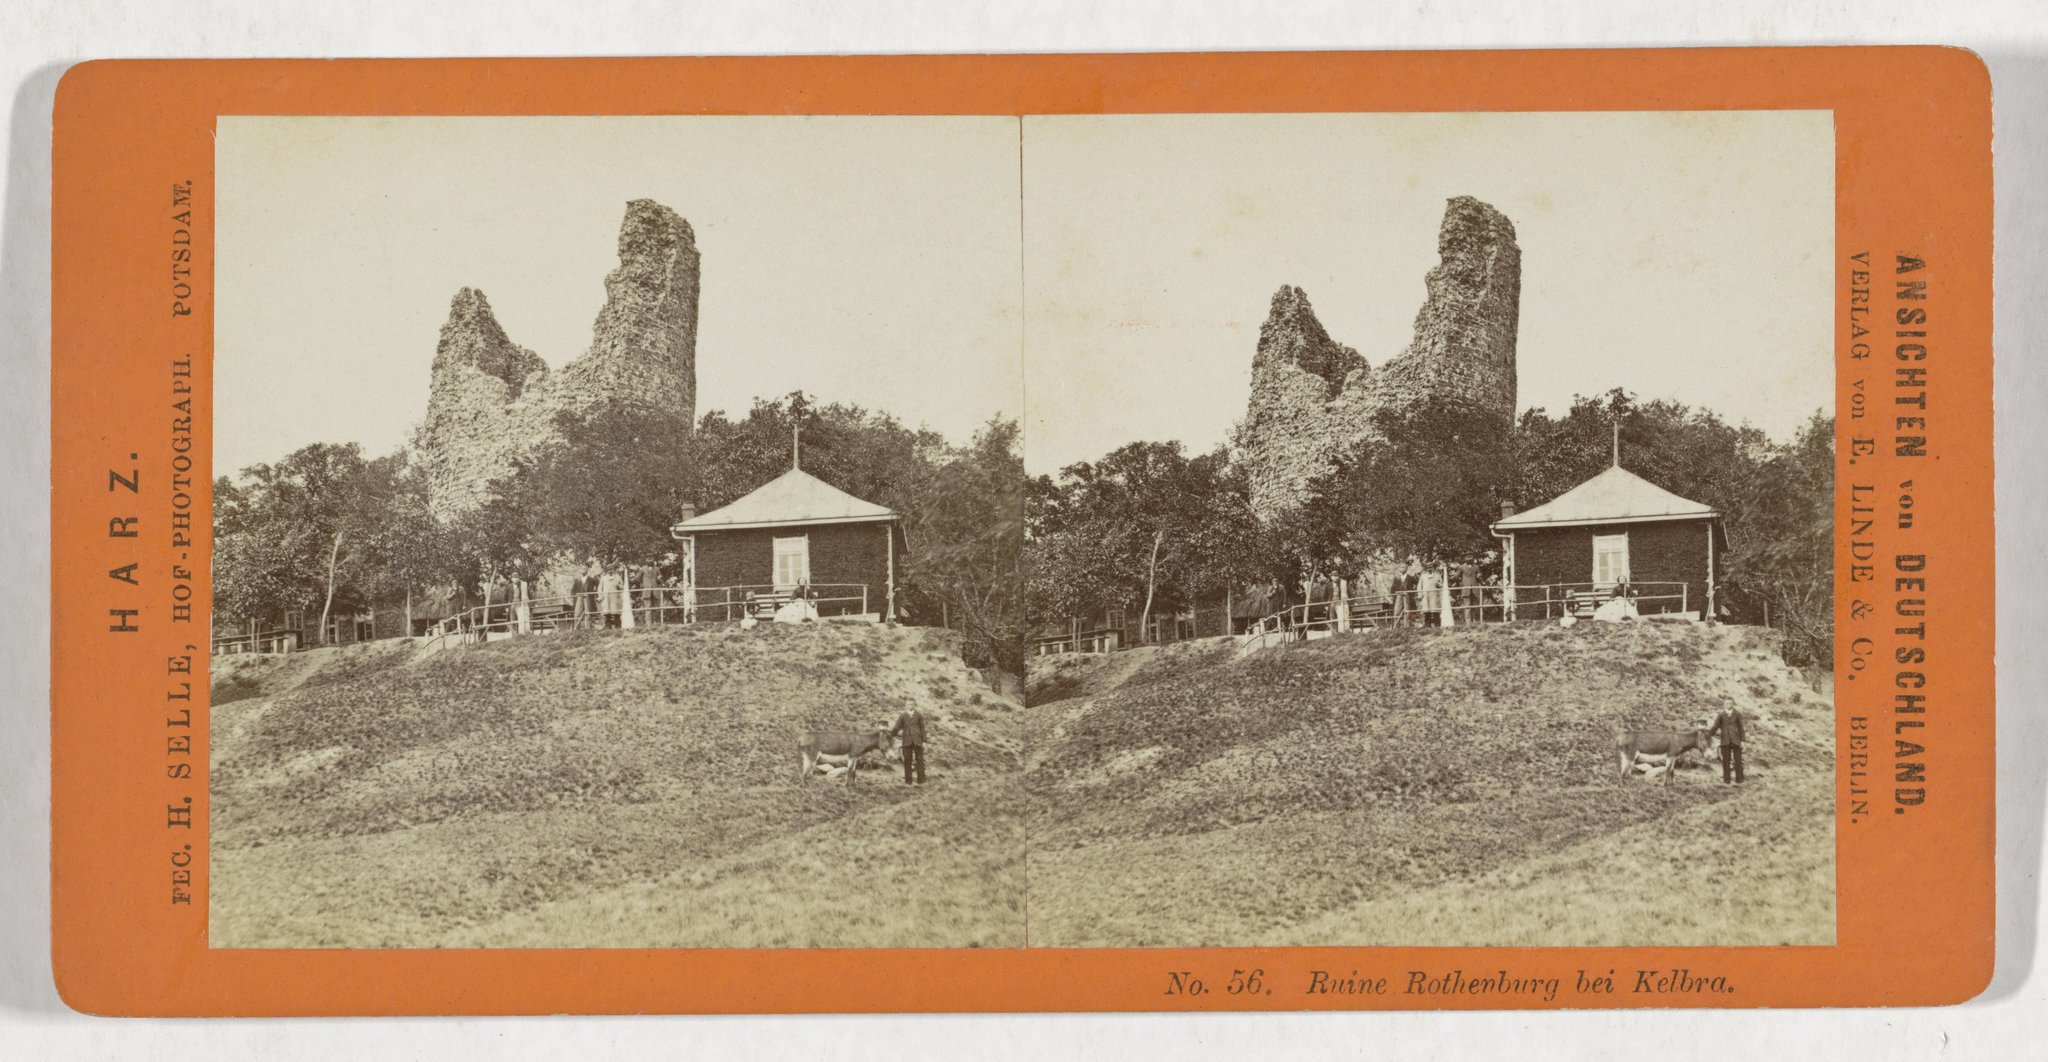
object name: stereograph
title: Ruïne Rothenburg, nabij Kelbra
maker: hermann selle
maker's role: fotograaf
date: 1868-1890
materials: cardboard, paper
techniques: albumen print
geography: berlin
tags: ruin of a building ~ architecture, ruin of a dwelling, house, castle, etc.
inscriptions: inscription: ‘Hof-Photograph. Potsdam.’, number: ‘No. 56.’